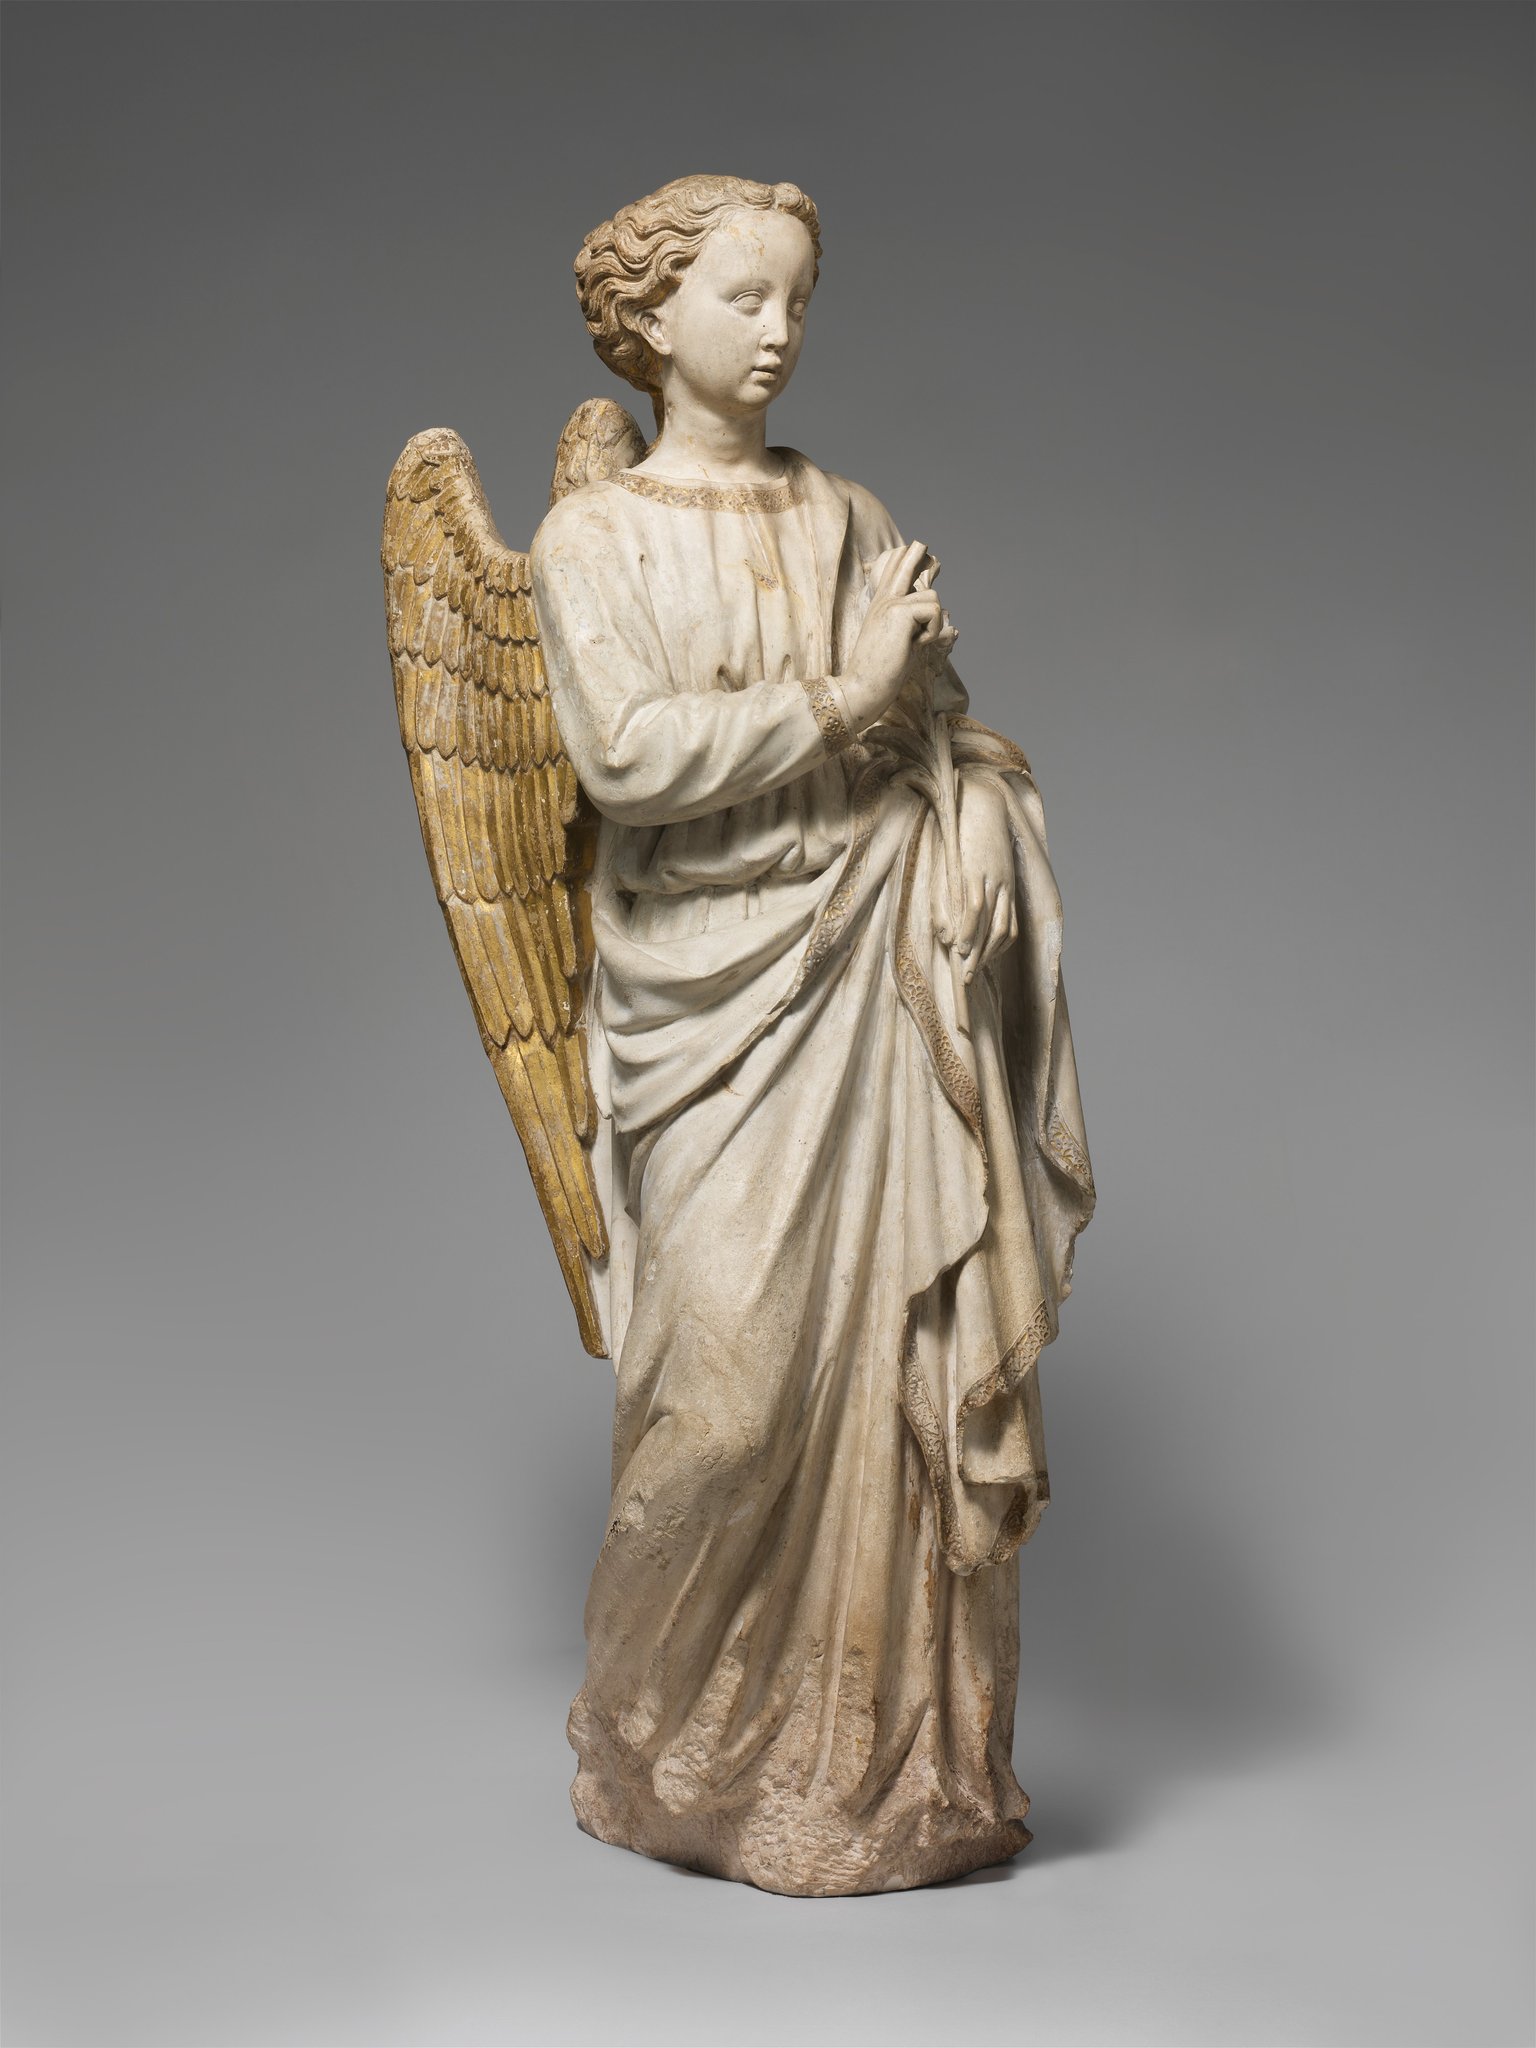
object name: statue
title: Angel of the Annunciation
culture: italian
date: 1430-1440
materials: mud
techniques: polychromy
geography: italy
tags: annunciation